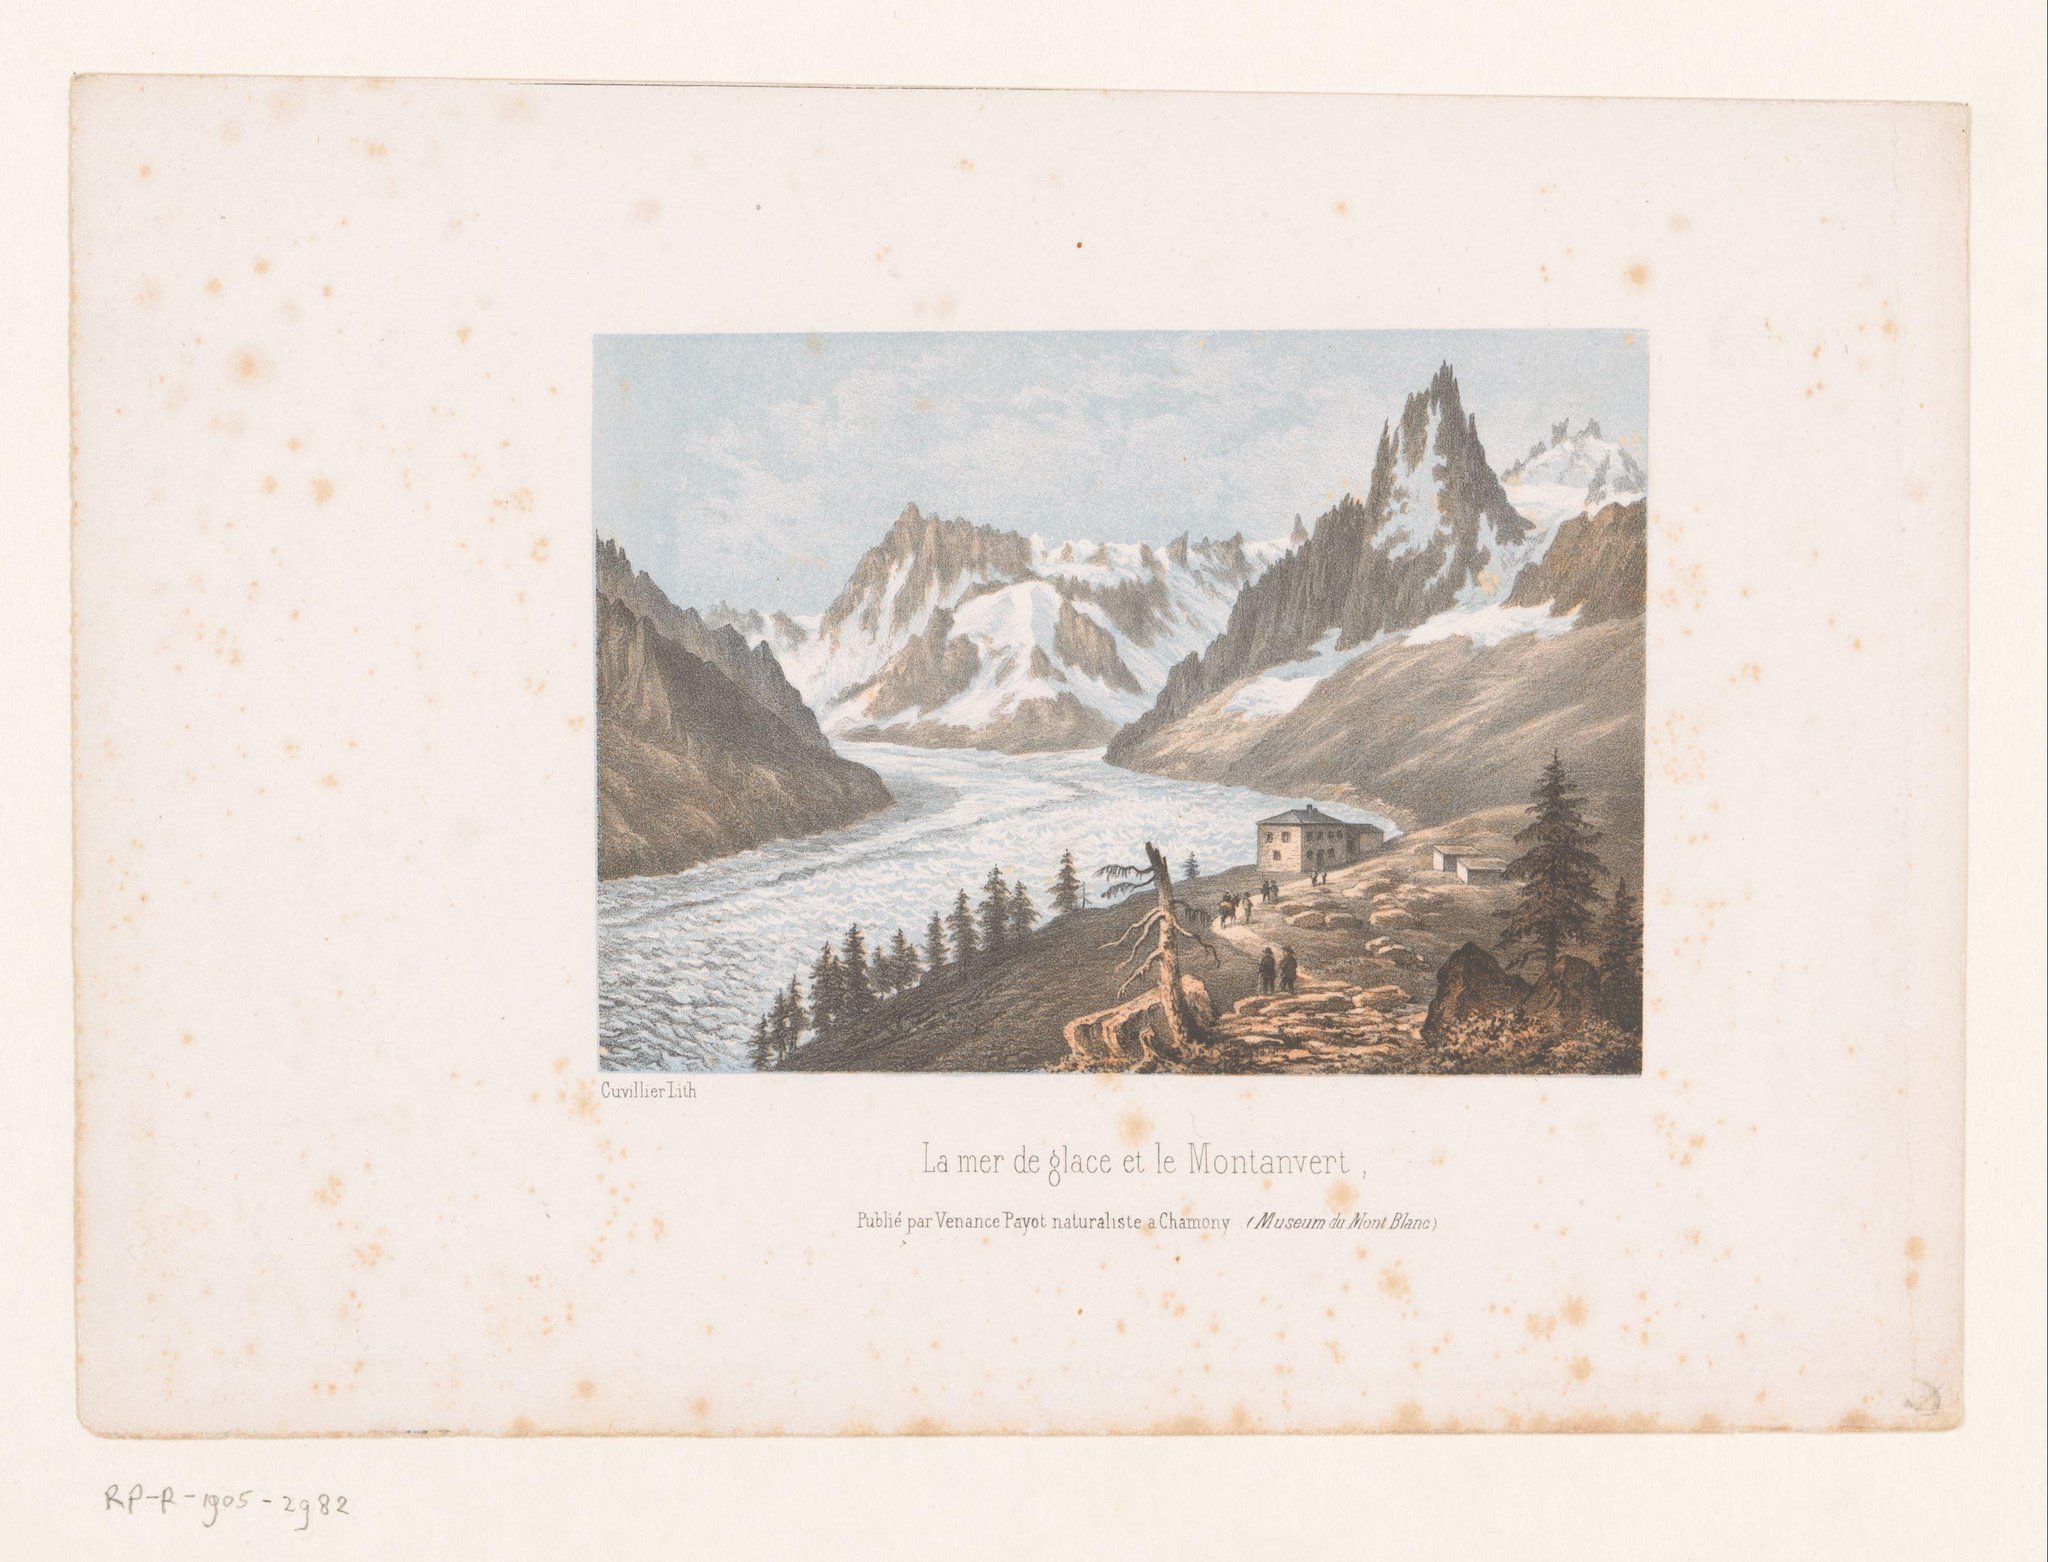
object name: print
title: Museum du Mont Blanc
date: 1840-1852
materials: paper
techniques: lithograph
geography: chamonix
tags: glacier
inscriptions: collector's mark: Lugt 2228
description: Gezicht op de gletsjer Mer de Glace en Montanvert in de vallei van de stad Chamonix. De stad ligt aan de voet van de Mont Blanc.